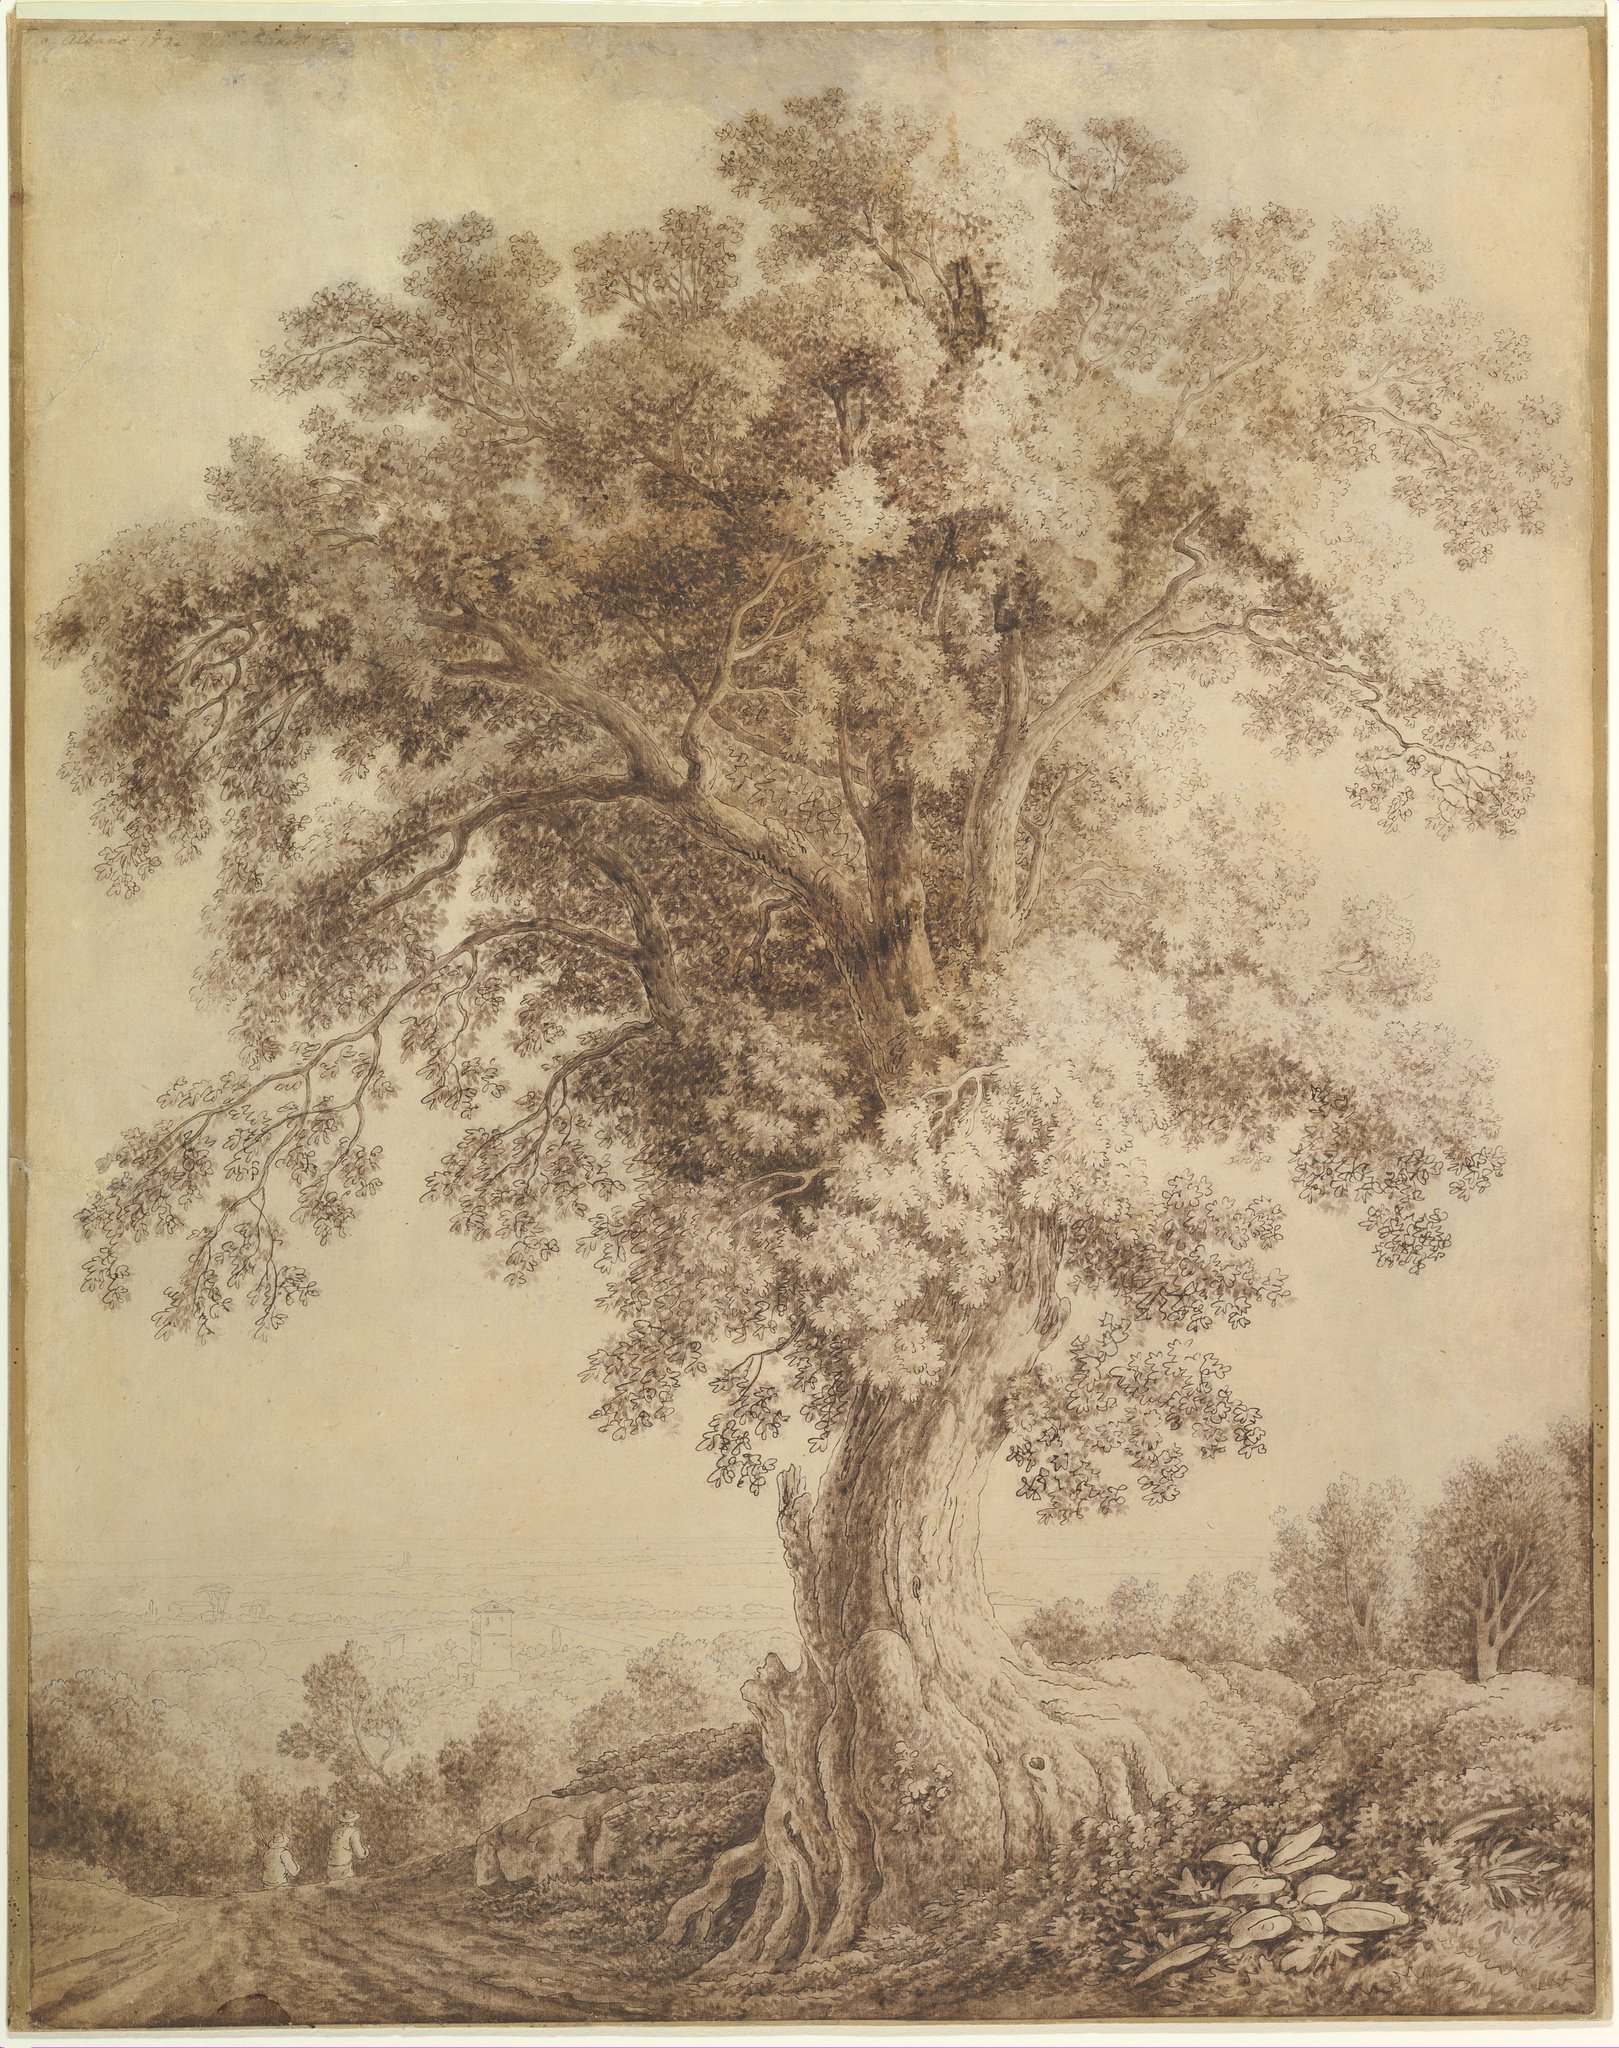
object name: drawing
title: A Large Tree at Albano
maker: jacob philipp hackert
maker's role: artist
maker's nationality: german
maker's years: 1737-1807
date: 1782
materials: graphite, ink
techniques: brush, pen, wash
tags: trees